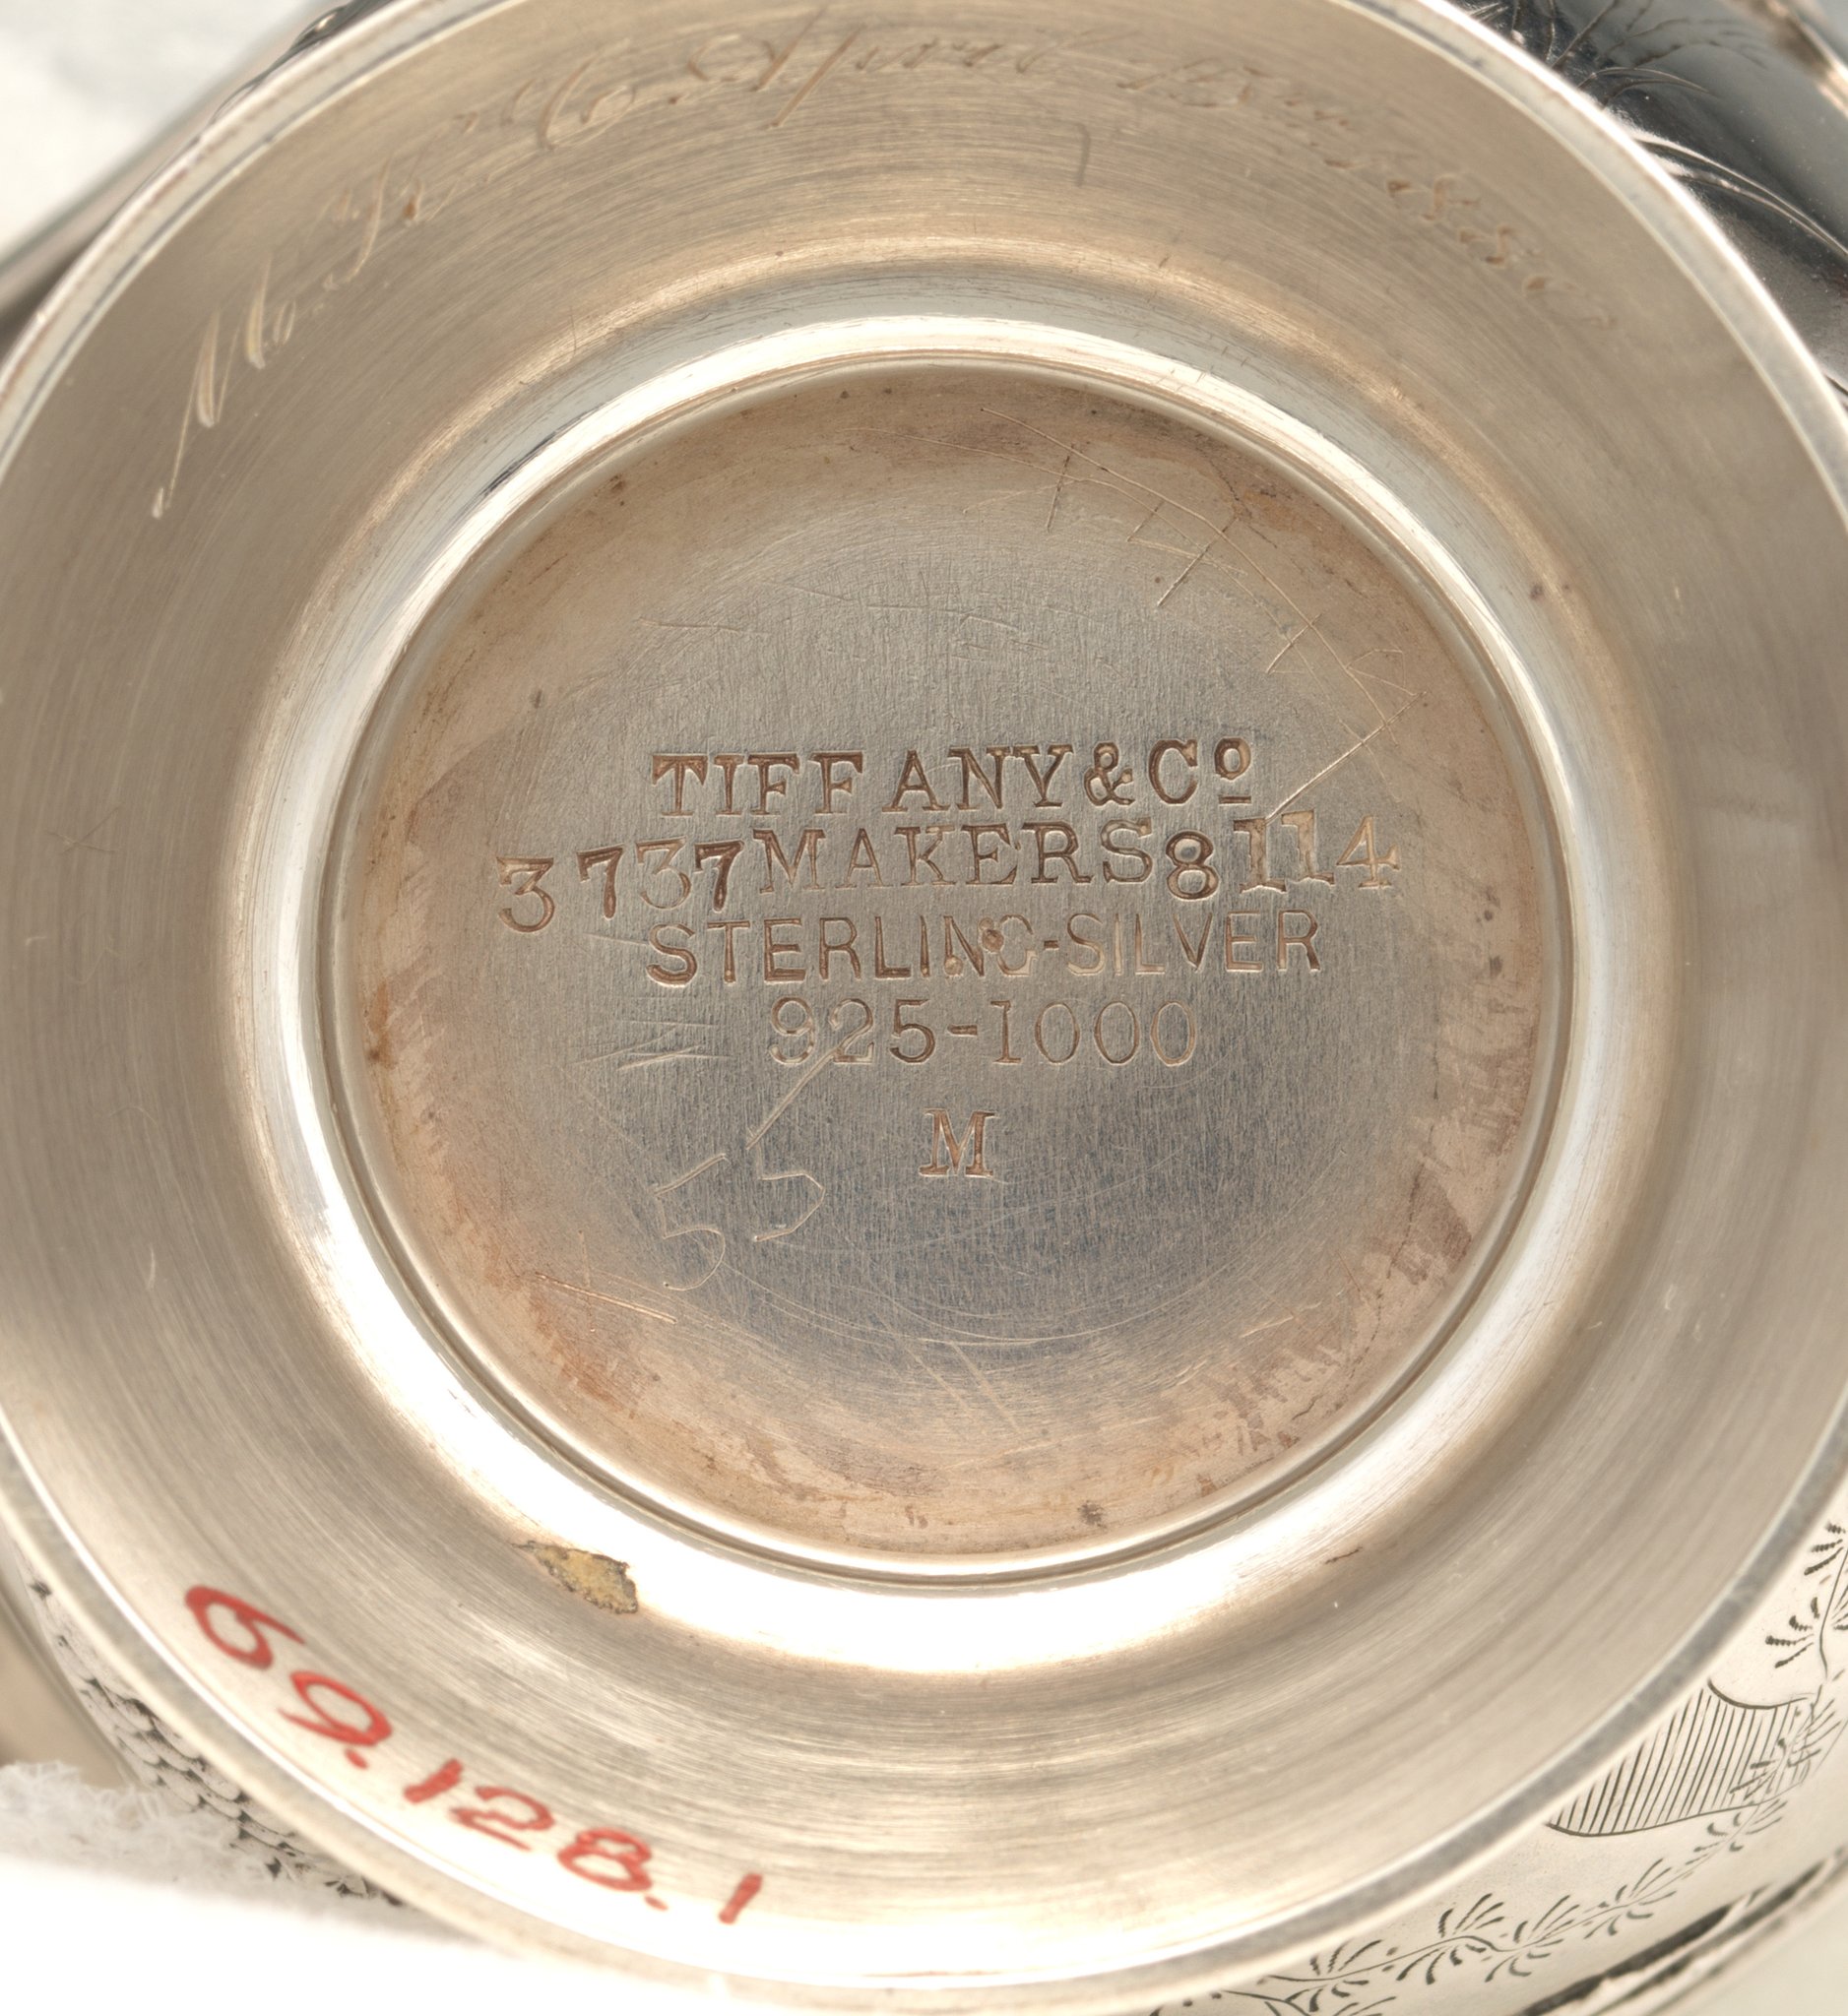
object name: cream pot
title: Creamer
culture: american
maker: tiffany & co.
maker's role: maker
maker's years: 1837-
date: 1876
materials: silver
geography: united states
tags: fish